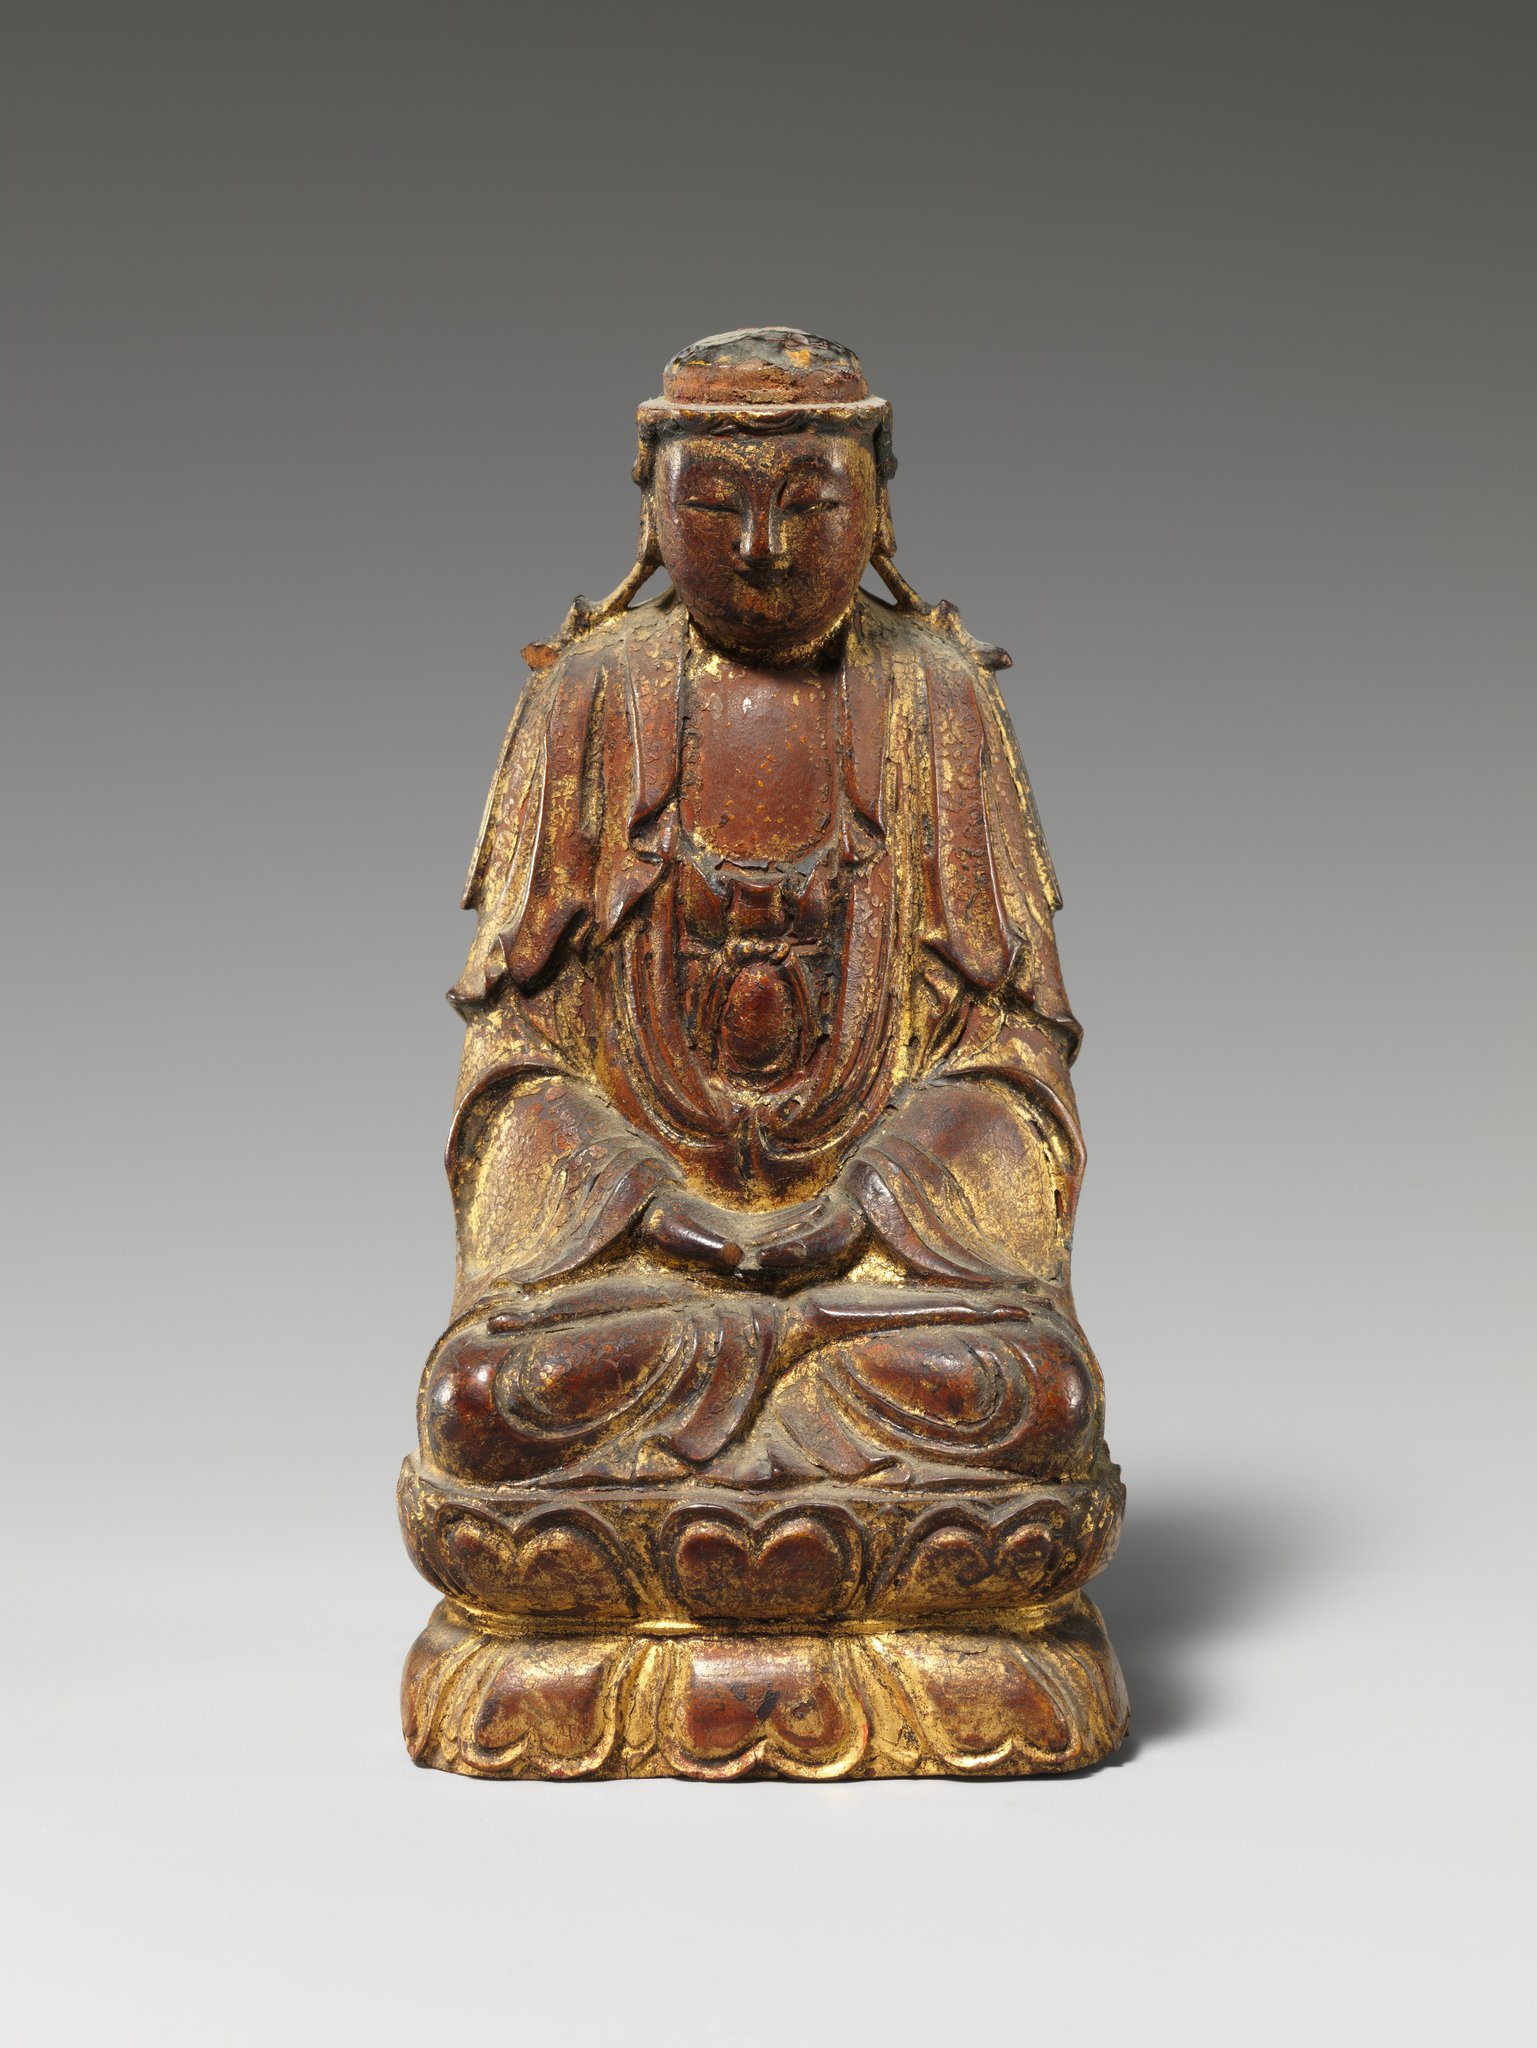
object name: figure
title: Bodhisattva Guanyin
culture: chinese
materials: lacquer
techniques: gilding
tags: avalokiteshvara,bodhisattvas